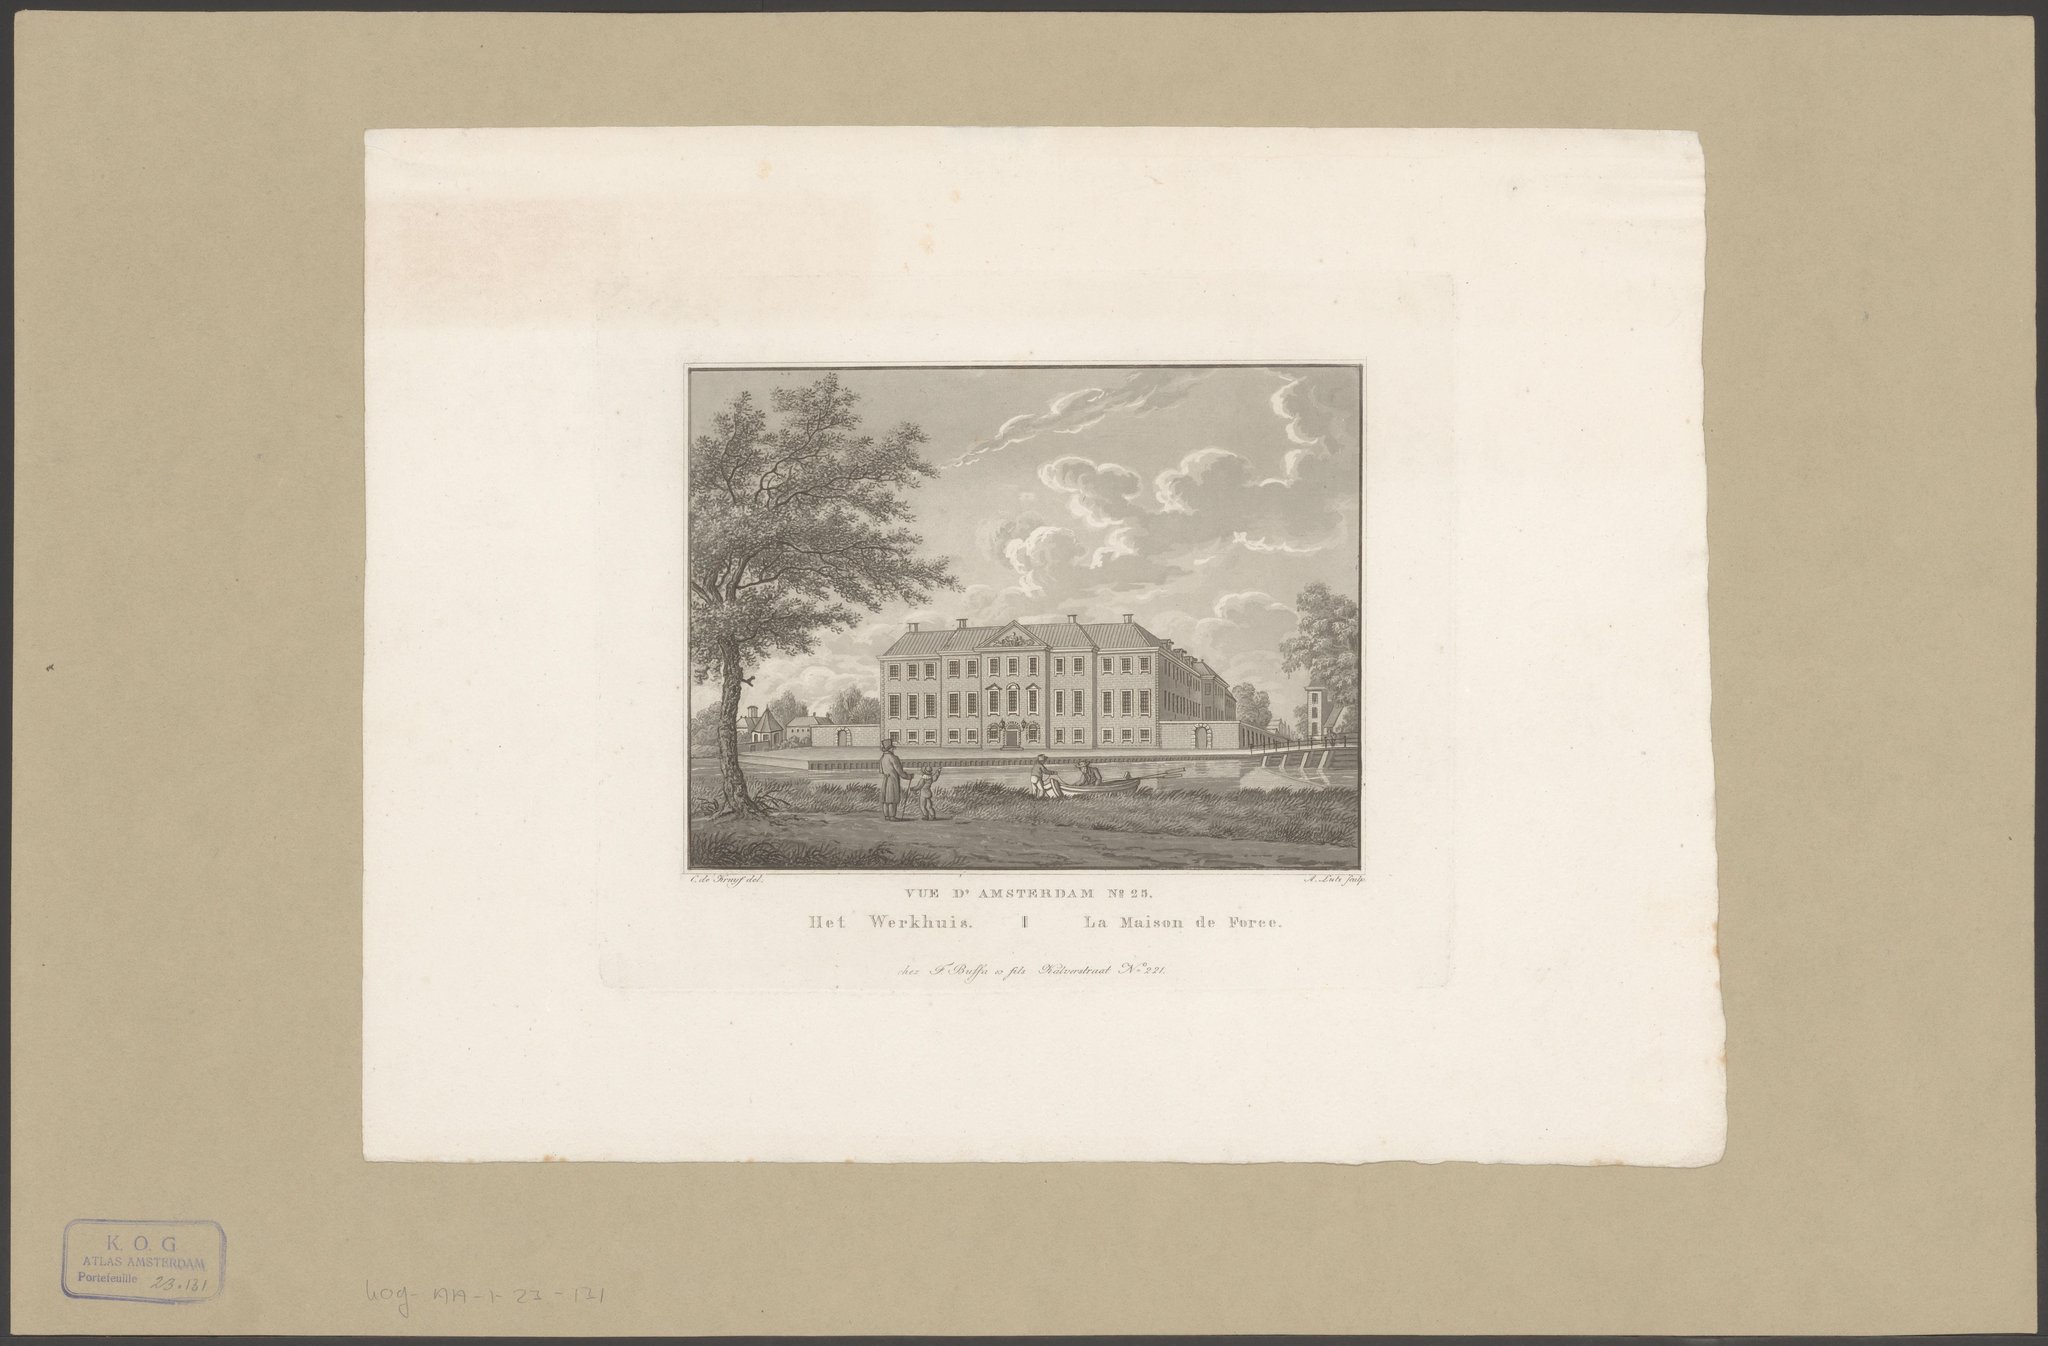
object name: print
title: Het Werkhuis / La Maison de Force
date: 1825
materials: paper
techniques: aquatint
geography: amsterdam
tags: prison, jail, canals, waters (in city), workhouse, penal camp, penitentiary, chain gang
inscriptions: collector's mark: Lugt 1641b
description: Prent maakt onderdeel uit van de serie: Vues choisies d'Amsterdam et ses Environs. Amsterdam: Frans Buffa en Zonen, 1825.